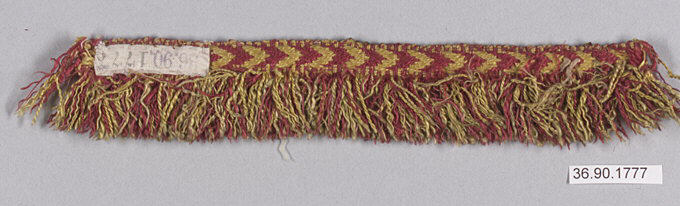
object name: fringe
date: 1801-1833